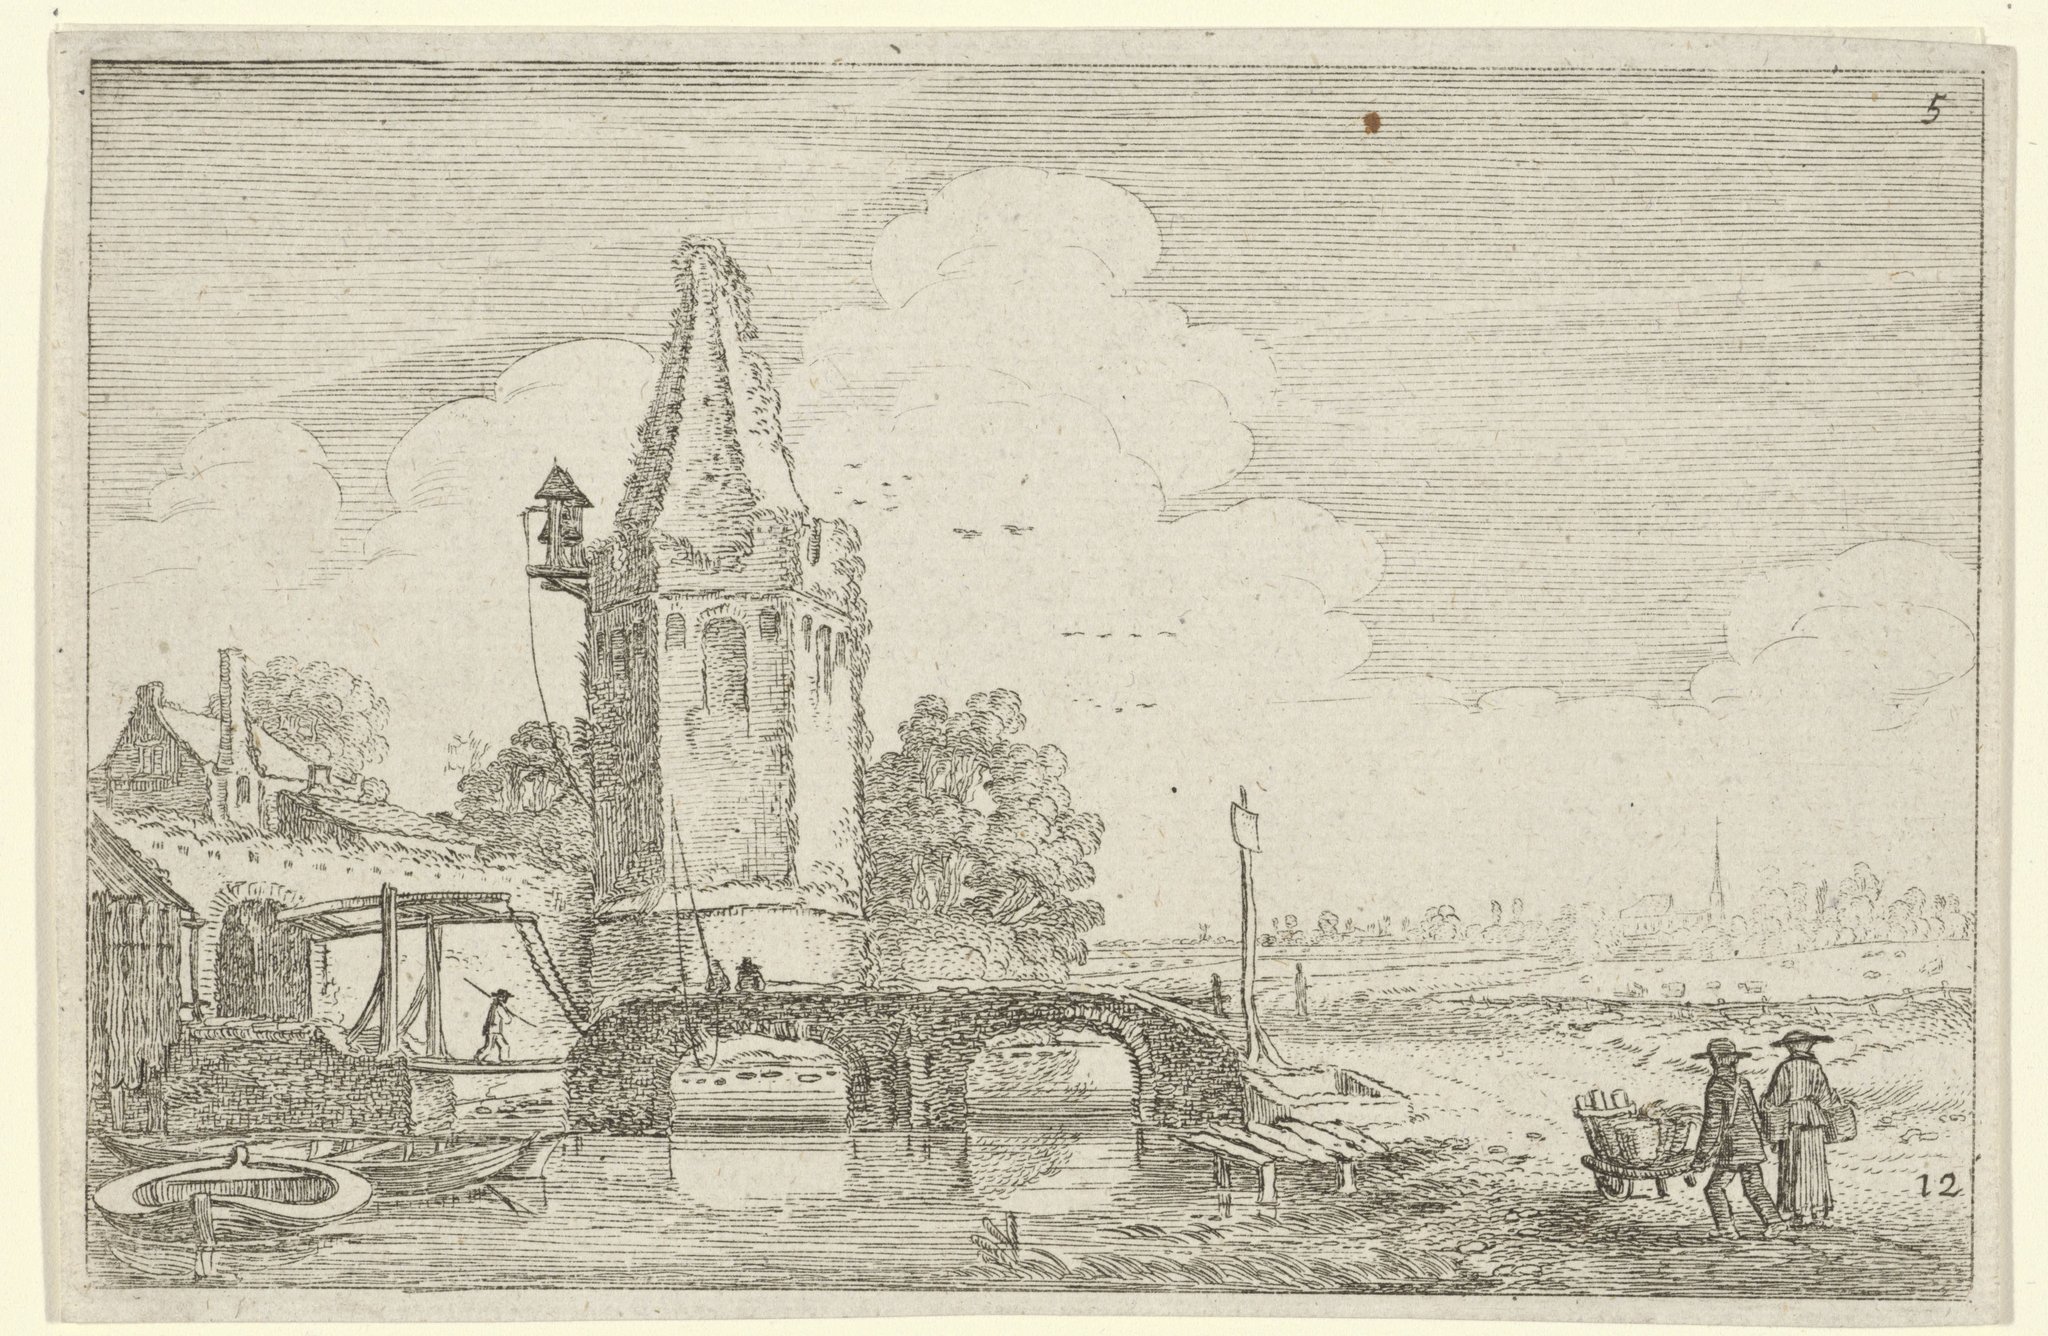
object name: print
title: Amenissimae aliquot requculae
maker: jan van de velde (ii)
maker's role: draughtsman, painter, print maker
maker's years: 1593-1641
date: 1616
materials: paper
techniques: etching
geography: northern netherlands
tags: drawbridge ~ fortified city, landscape with bridge, viaduct or aqueduct, landscape with tower or castle, wheelbarrow, village-gate, bridge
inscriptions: number: ‘10’, number: ‘5’, collector's mark: Lugt 2228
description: Figuren met een kruiwagen op een pad bij een brug en een toren in een landschap met de rivier de Niers. Links de ingang van een dorp met daarvoor een ophaalbrug. Twaalfde prent van deel vijf van een serie van in totaal zestig prenten met landschappen, verdeeld over vijf delen van elk twaalf prenten.